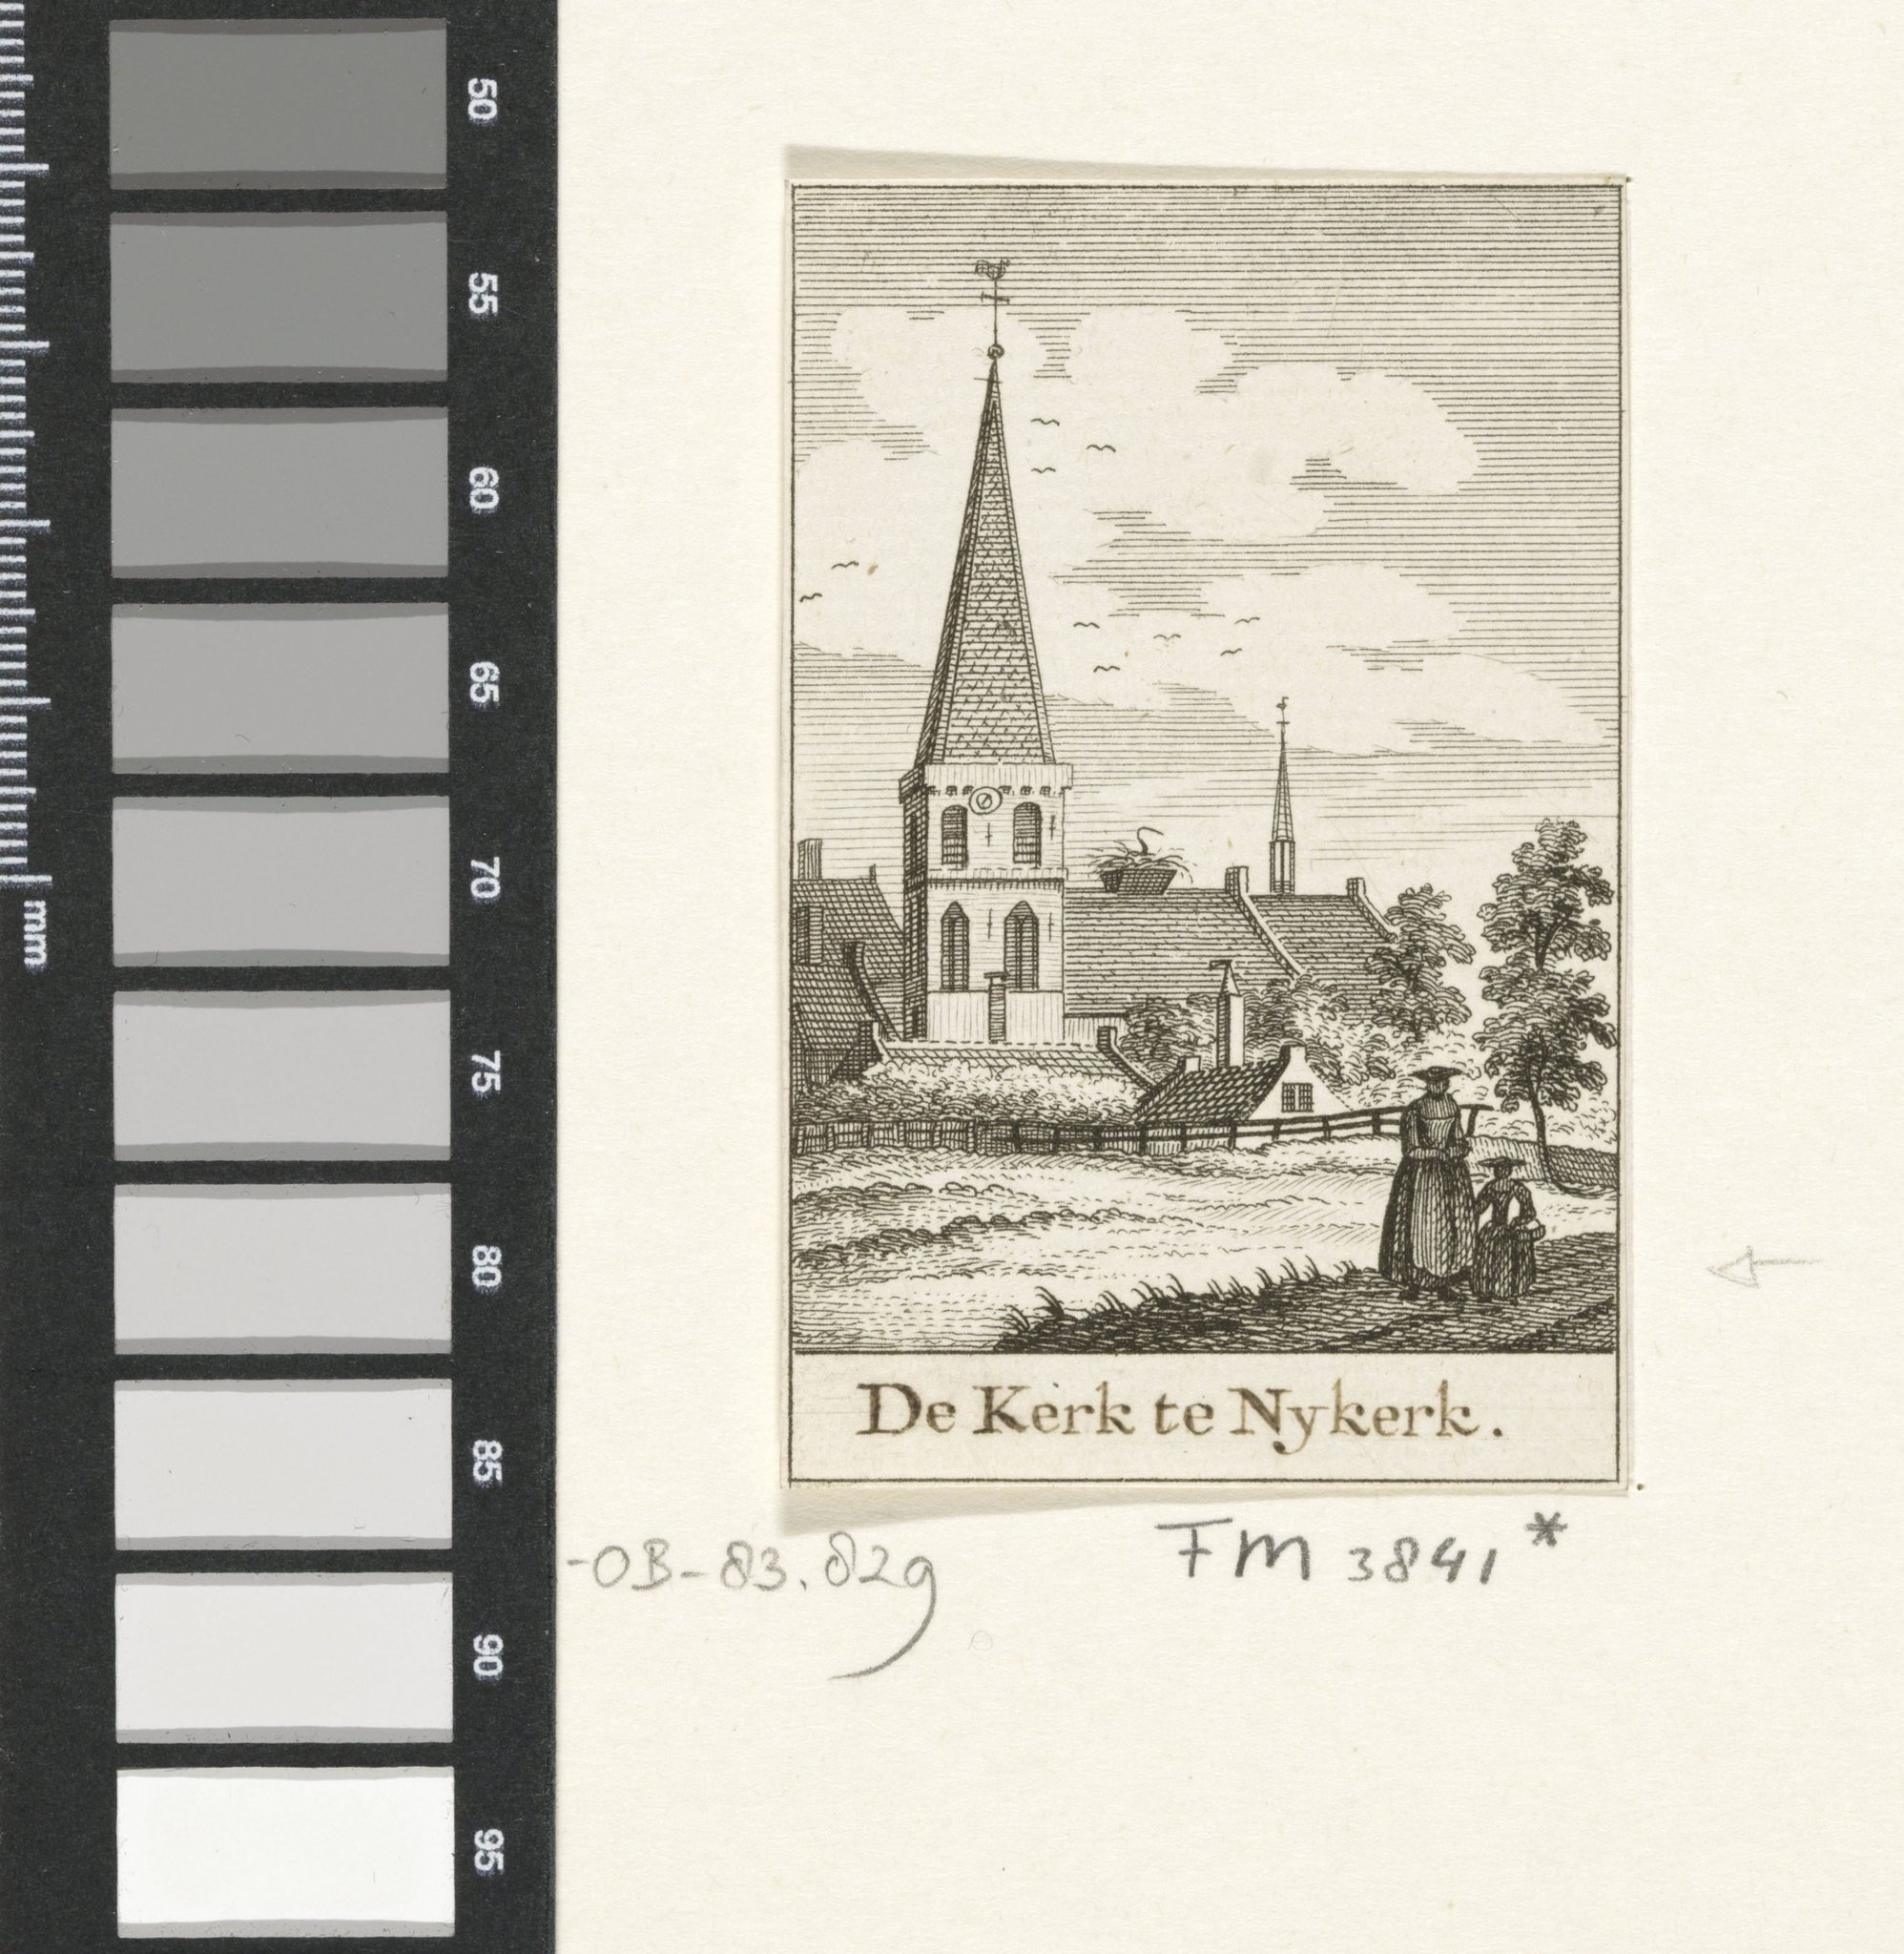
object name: print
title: De kerk te Nijkerk, ca. 1749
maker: Anonymous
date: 1700-1799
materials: paper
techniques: etching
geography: northern netherlands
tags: church (exterior)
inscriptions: collector's mark: Lugt 2228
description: Gezicht op de kerk te Nijkerk. Toegevoegd aan de prenten van de Nijkerkse Beroeringen in 1749.